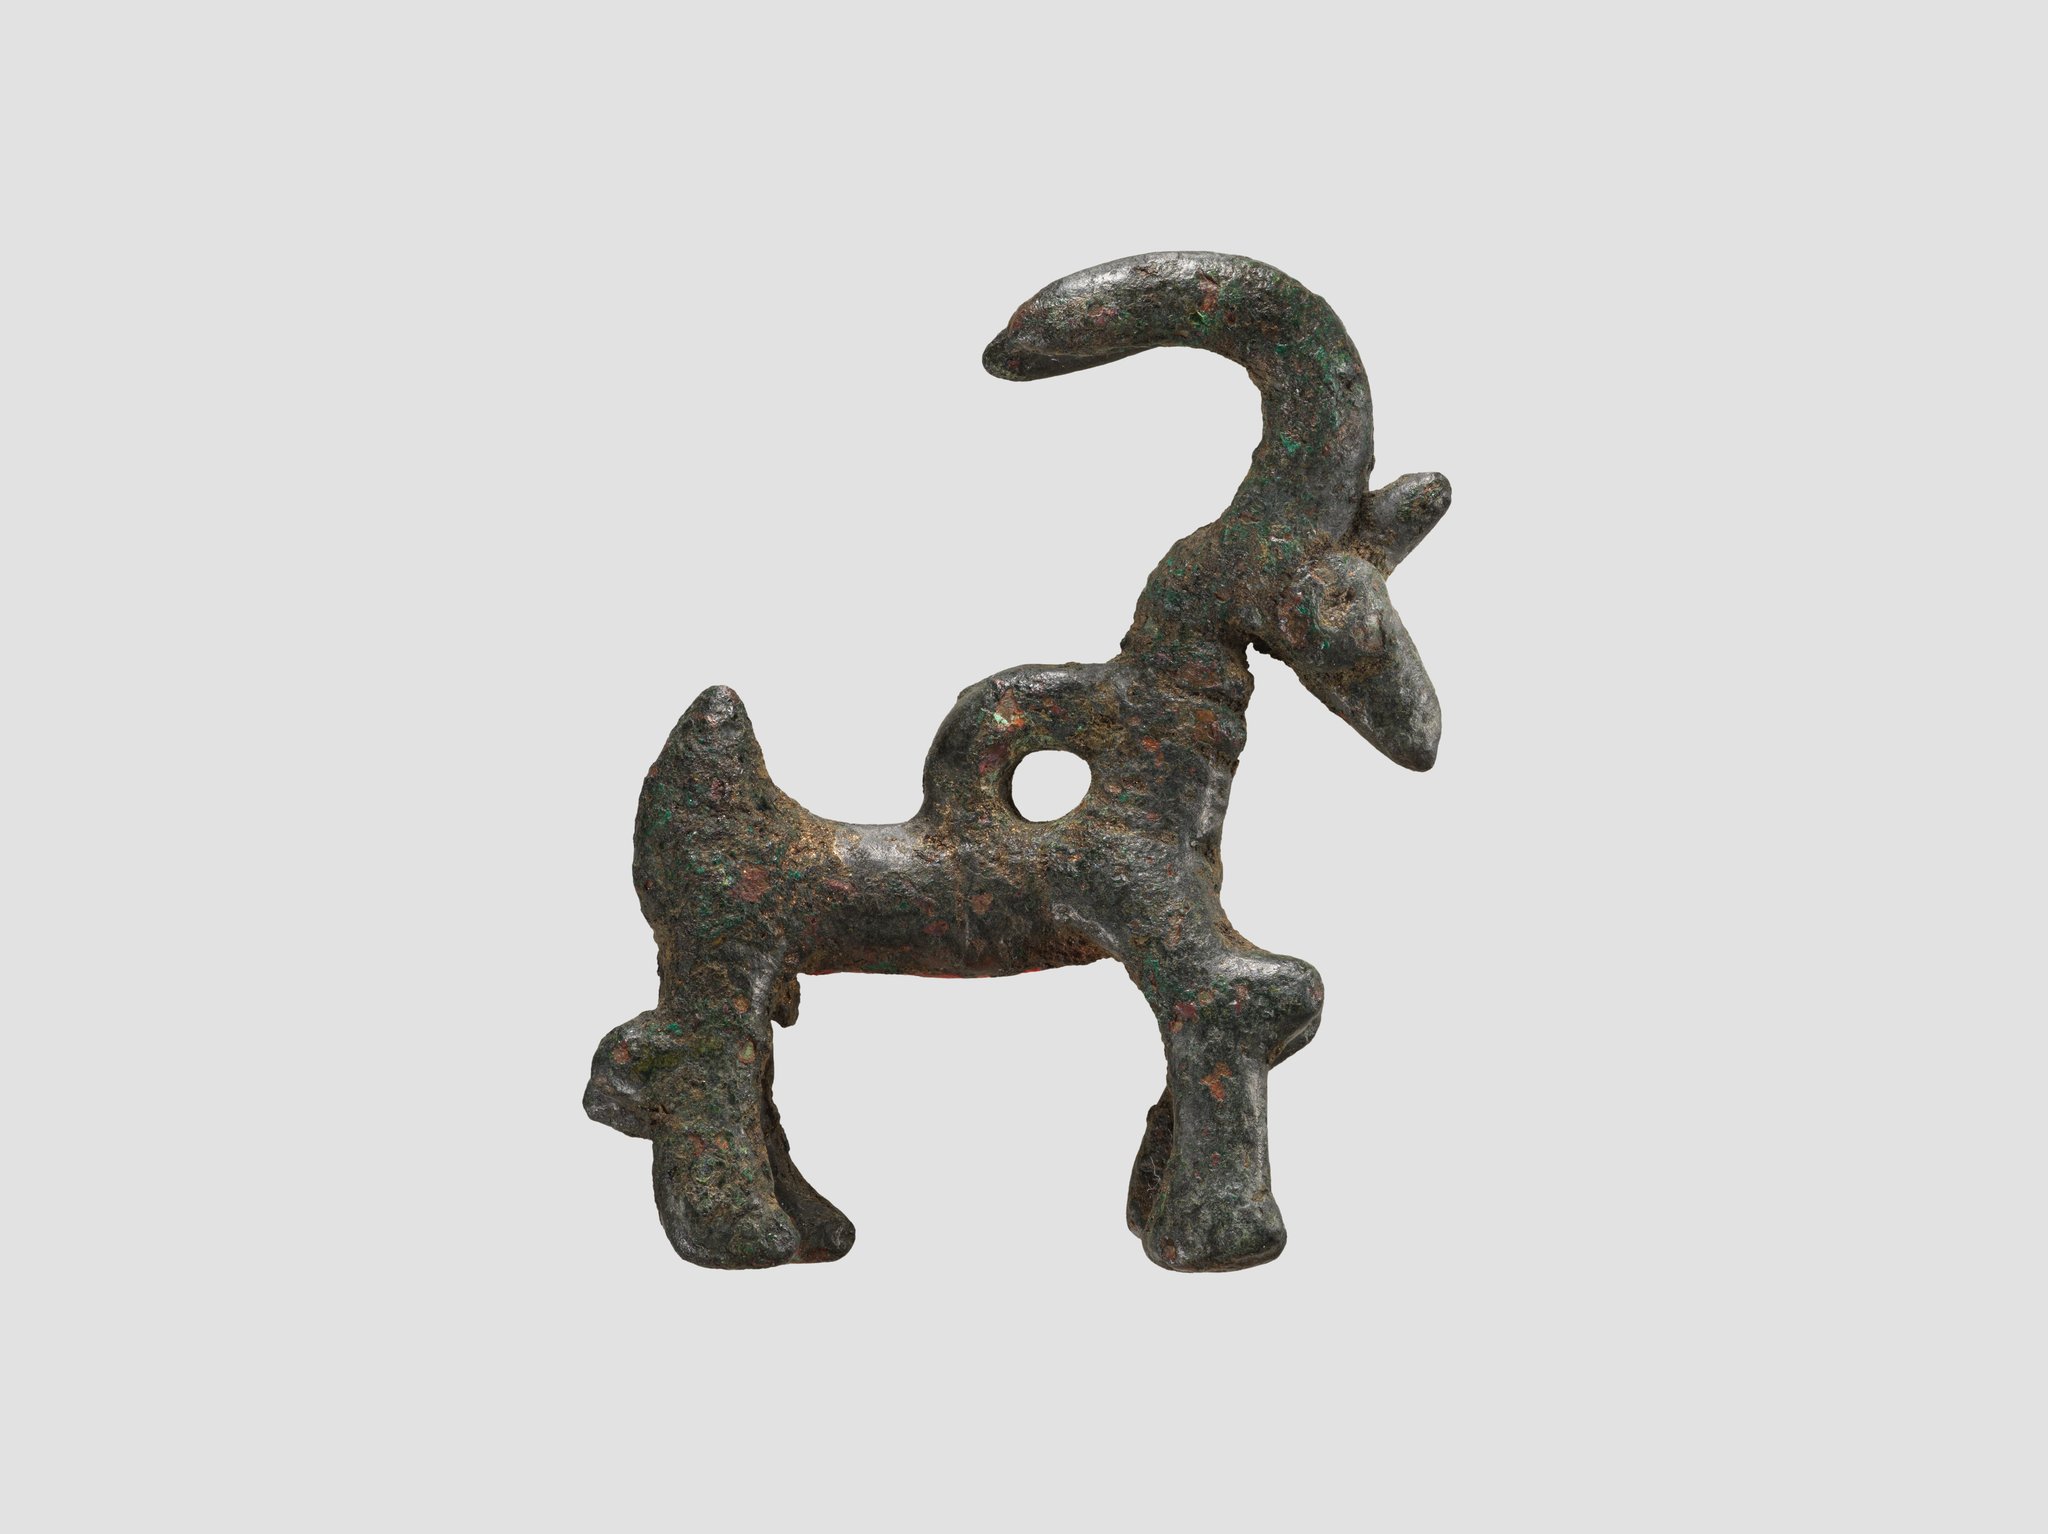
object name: pendant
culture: iranian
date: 800-601 BCE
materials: bronze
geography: iran, probably from luristan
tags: animals